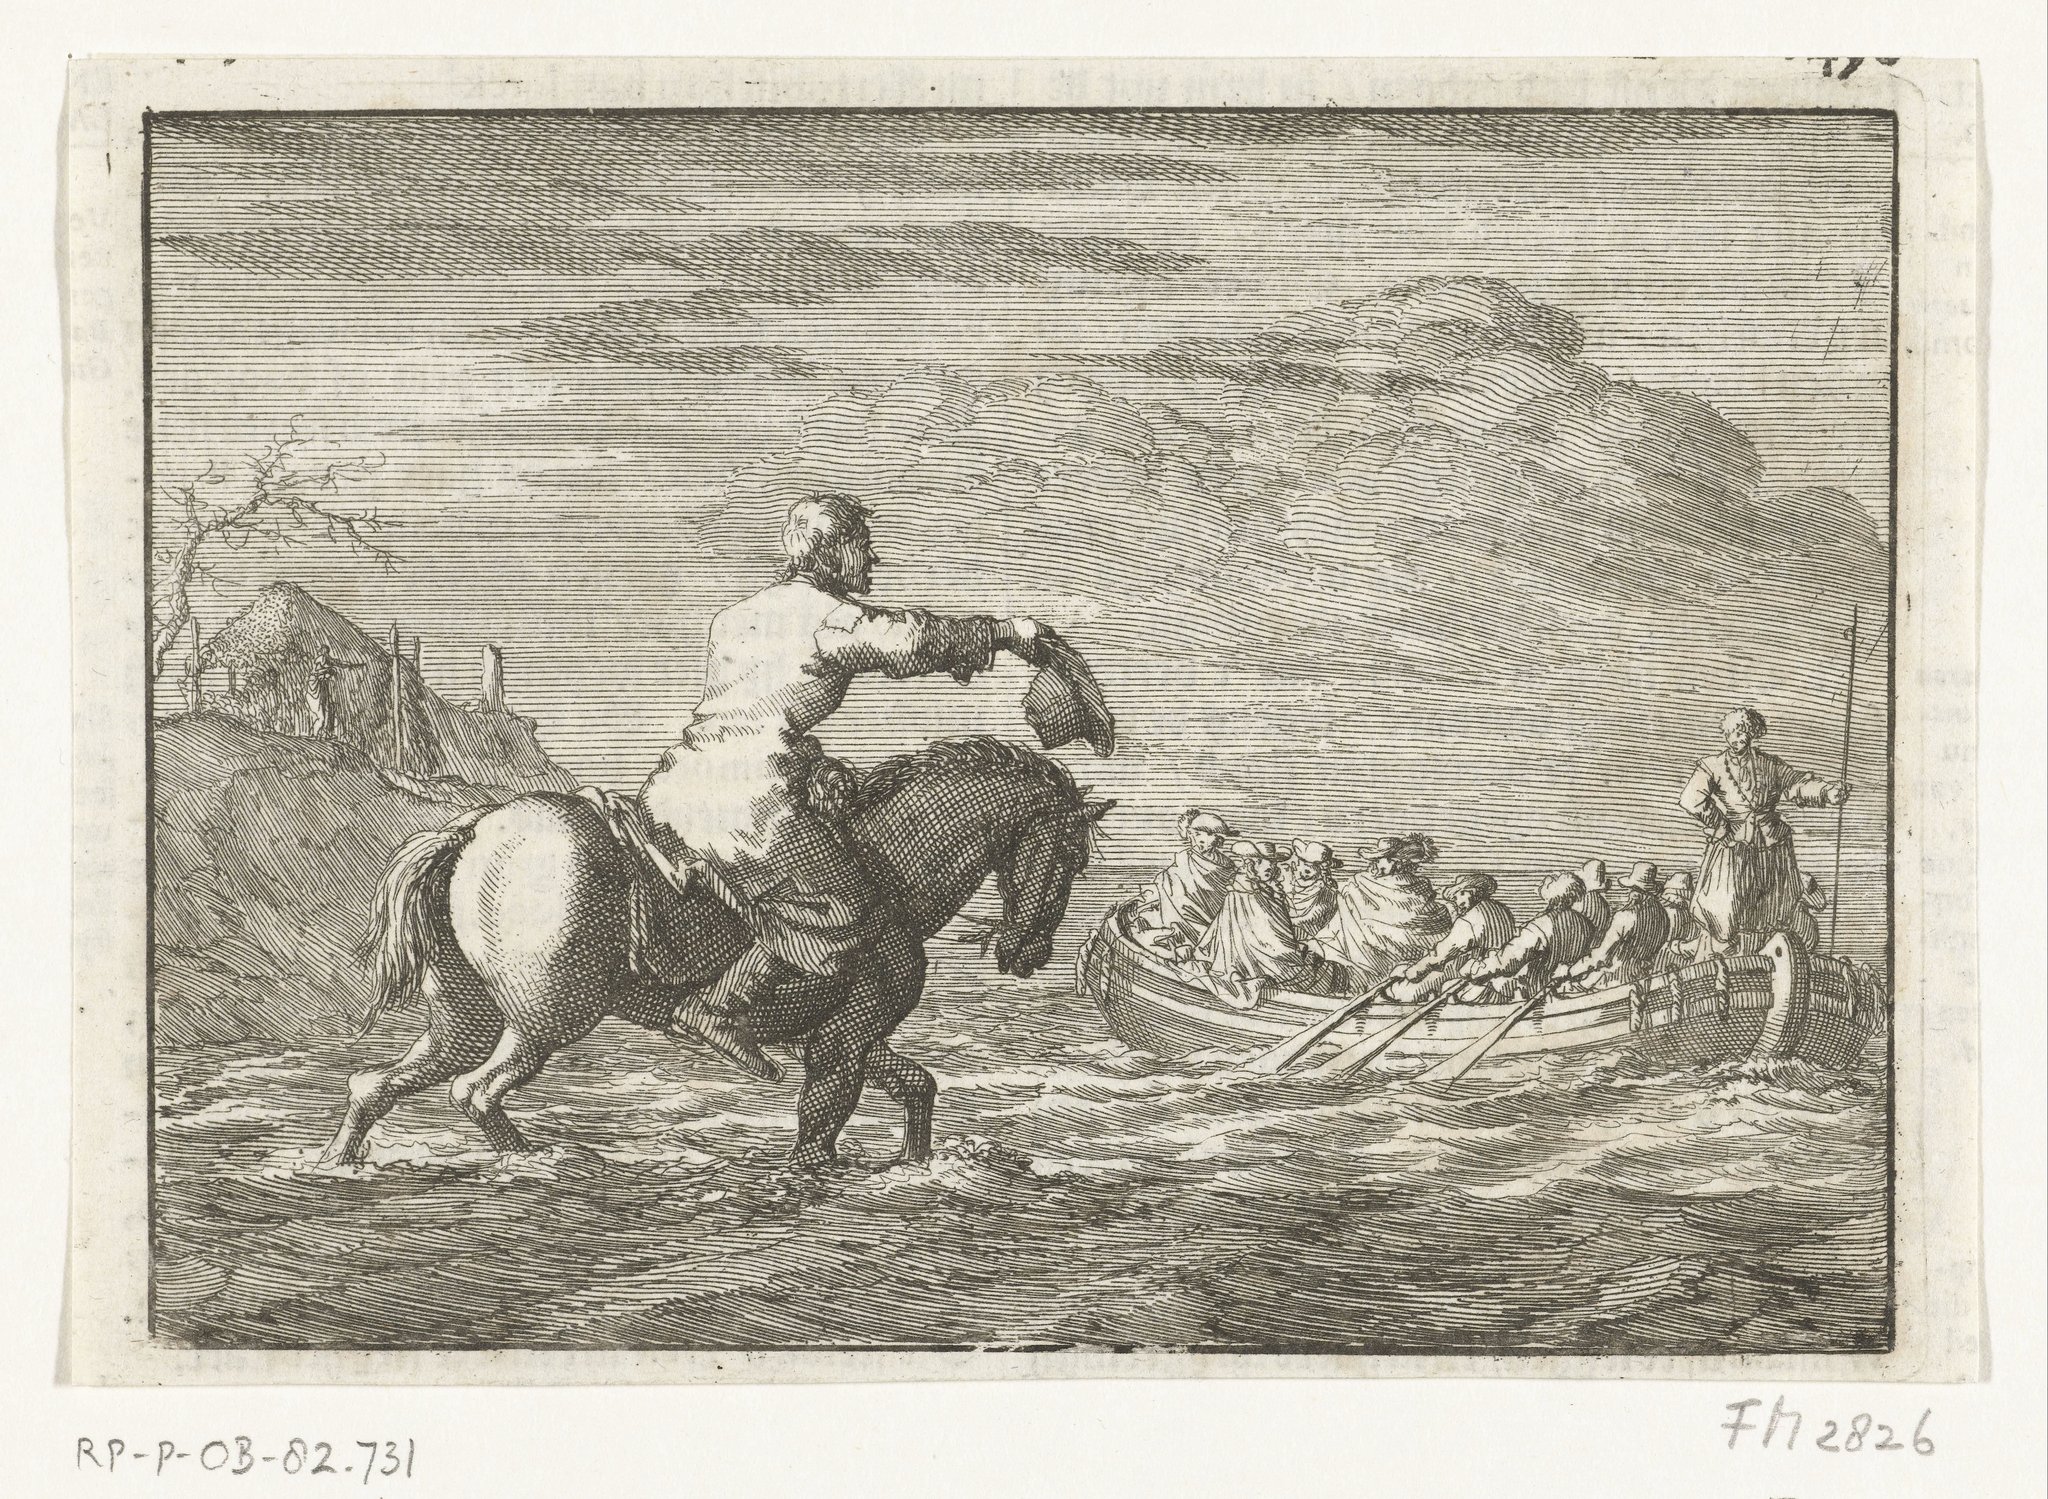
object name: book illustration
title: Aankomst van koning Willem III bij Oranjepolder, 1691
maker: jan luyken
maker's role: draughtsman, print maker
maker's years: 1649-1712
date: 1696-1700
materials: paper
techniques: etching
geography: northern netherlands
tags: the hague, william iii (prince of orange and king of england, scotland, and ireland), arrival and return ~ travelling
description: De aankomst van de sloep met koning Willem III bij Oranjepolder in Zuid-Holland, 31 januari 1691. Een boer genaamd Jillis komt te paard de boot tegemoet. Bedrukt met tekst op achterzijde.